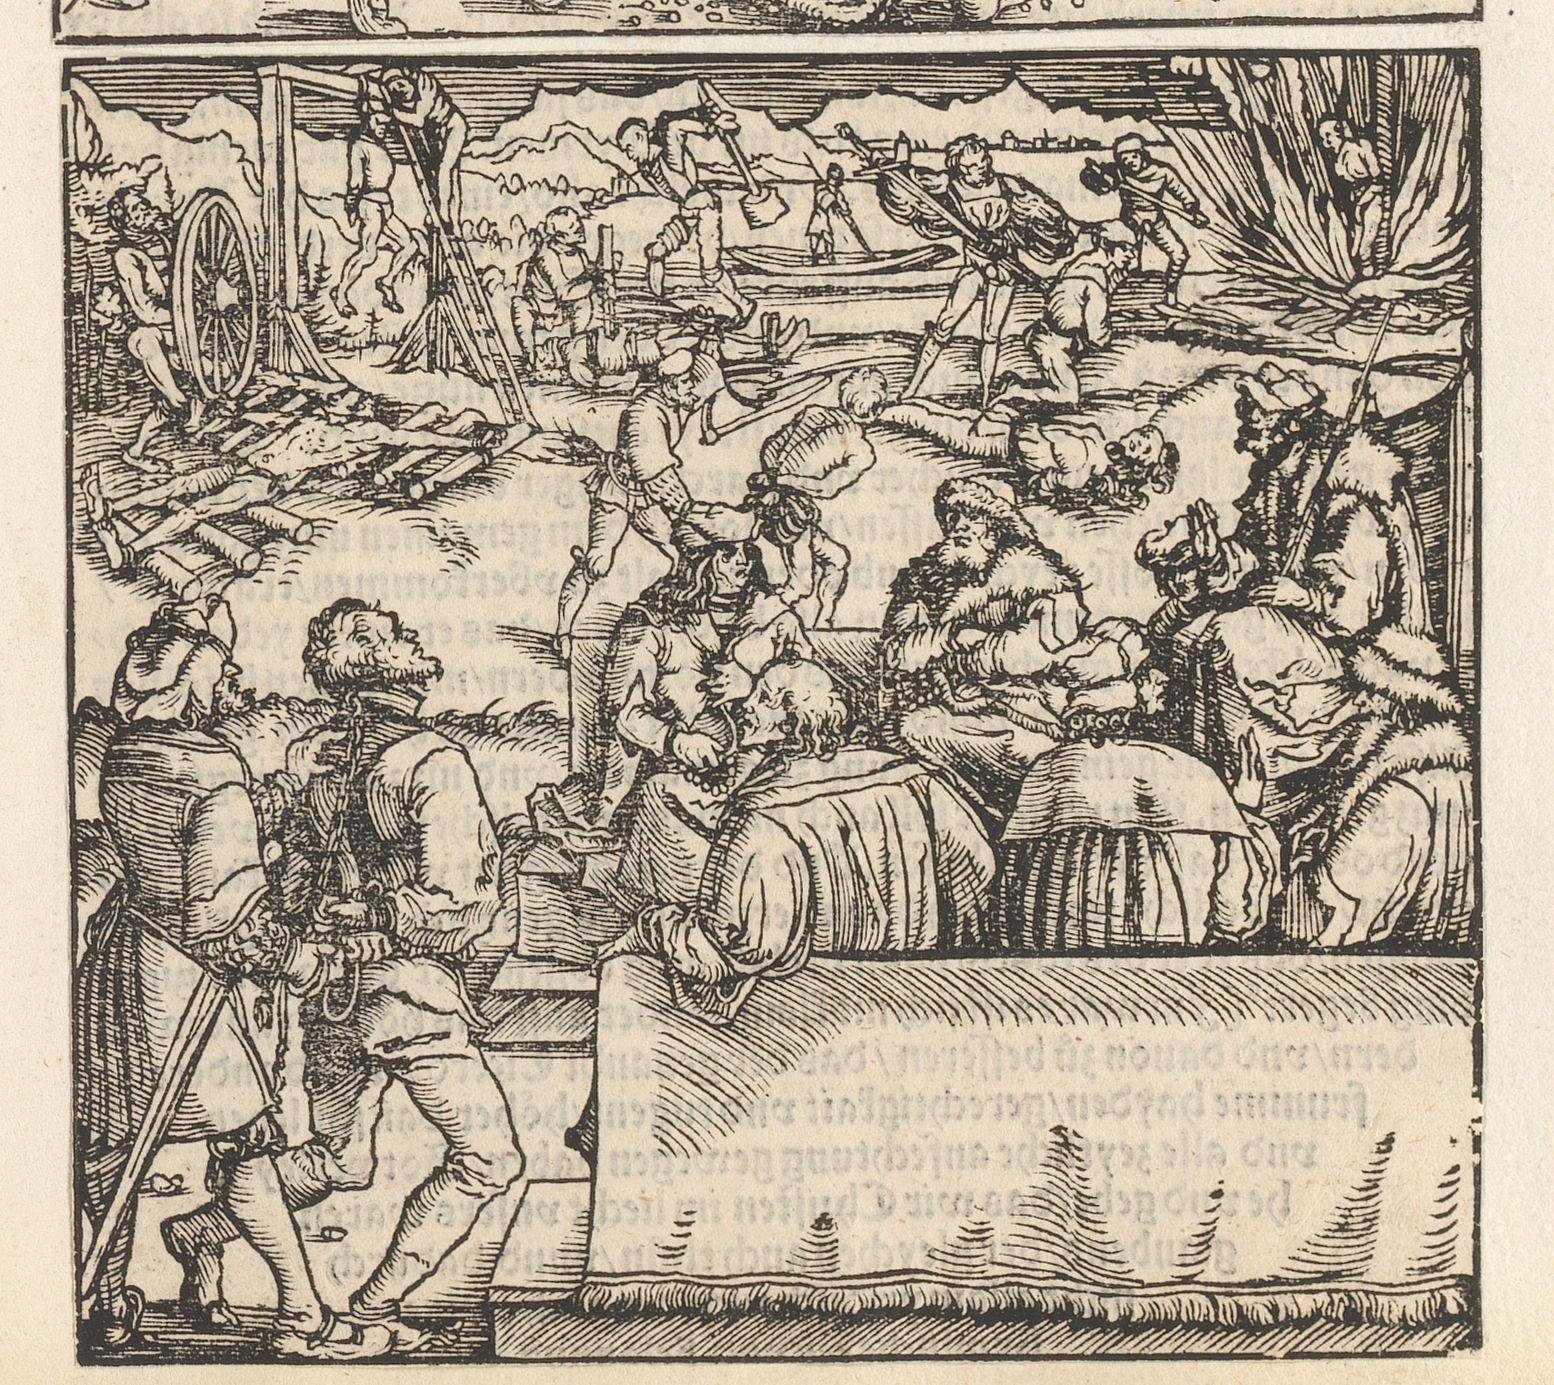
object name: album leaf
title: Gevangene wordt voorgeleid en achteraan dodelijke martelmethodes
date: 1514-1532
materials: paper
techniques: letterpress printing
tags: jury, violent death by burning at the stake; pyre, violent death ~ maltreatment, torture, corporal punishment in public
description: Deze prent is gebruikt in: Petrarca, Francesco. Von der Artzney bayder Glück, des guten und widerwertigen: unnd weß sich ain yeder inn Gelück und Unglück halten sol (...). Augsburg: Heinrich Steiner, 1532. Deze uitgave is ook bekend onder de titel 'Trostspiegel in Glück und Unglück'. Deze prent is ook gebruikt in: Cicero, Marcus Tulius. Officia M.T.C. Ein Buch so Marcus Tullius Cicero der Römer zu seynem (...). [Vertaald uit het Latijn door] Johann von Schwarzenberg. Augsburg: Heinrich Steiner, 1531.